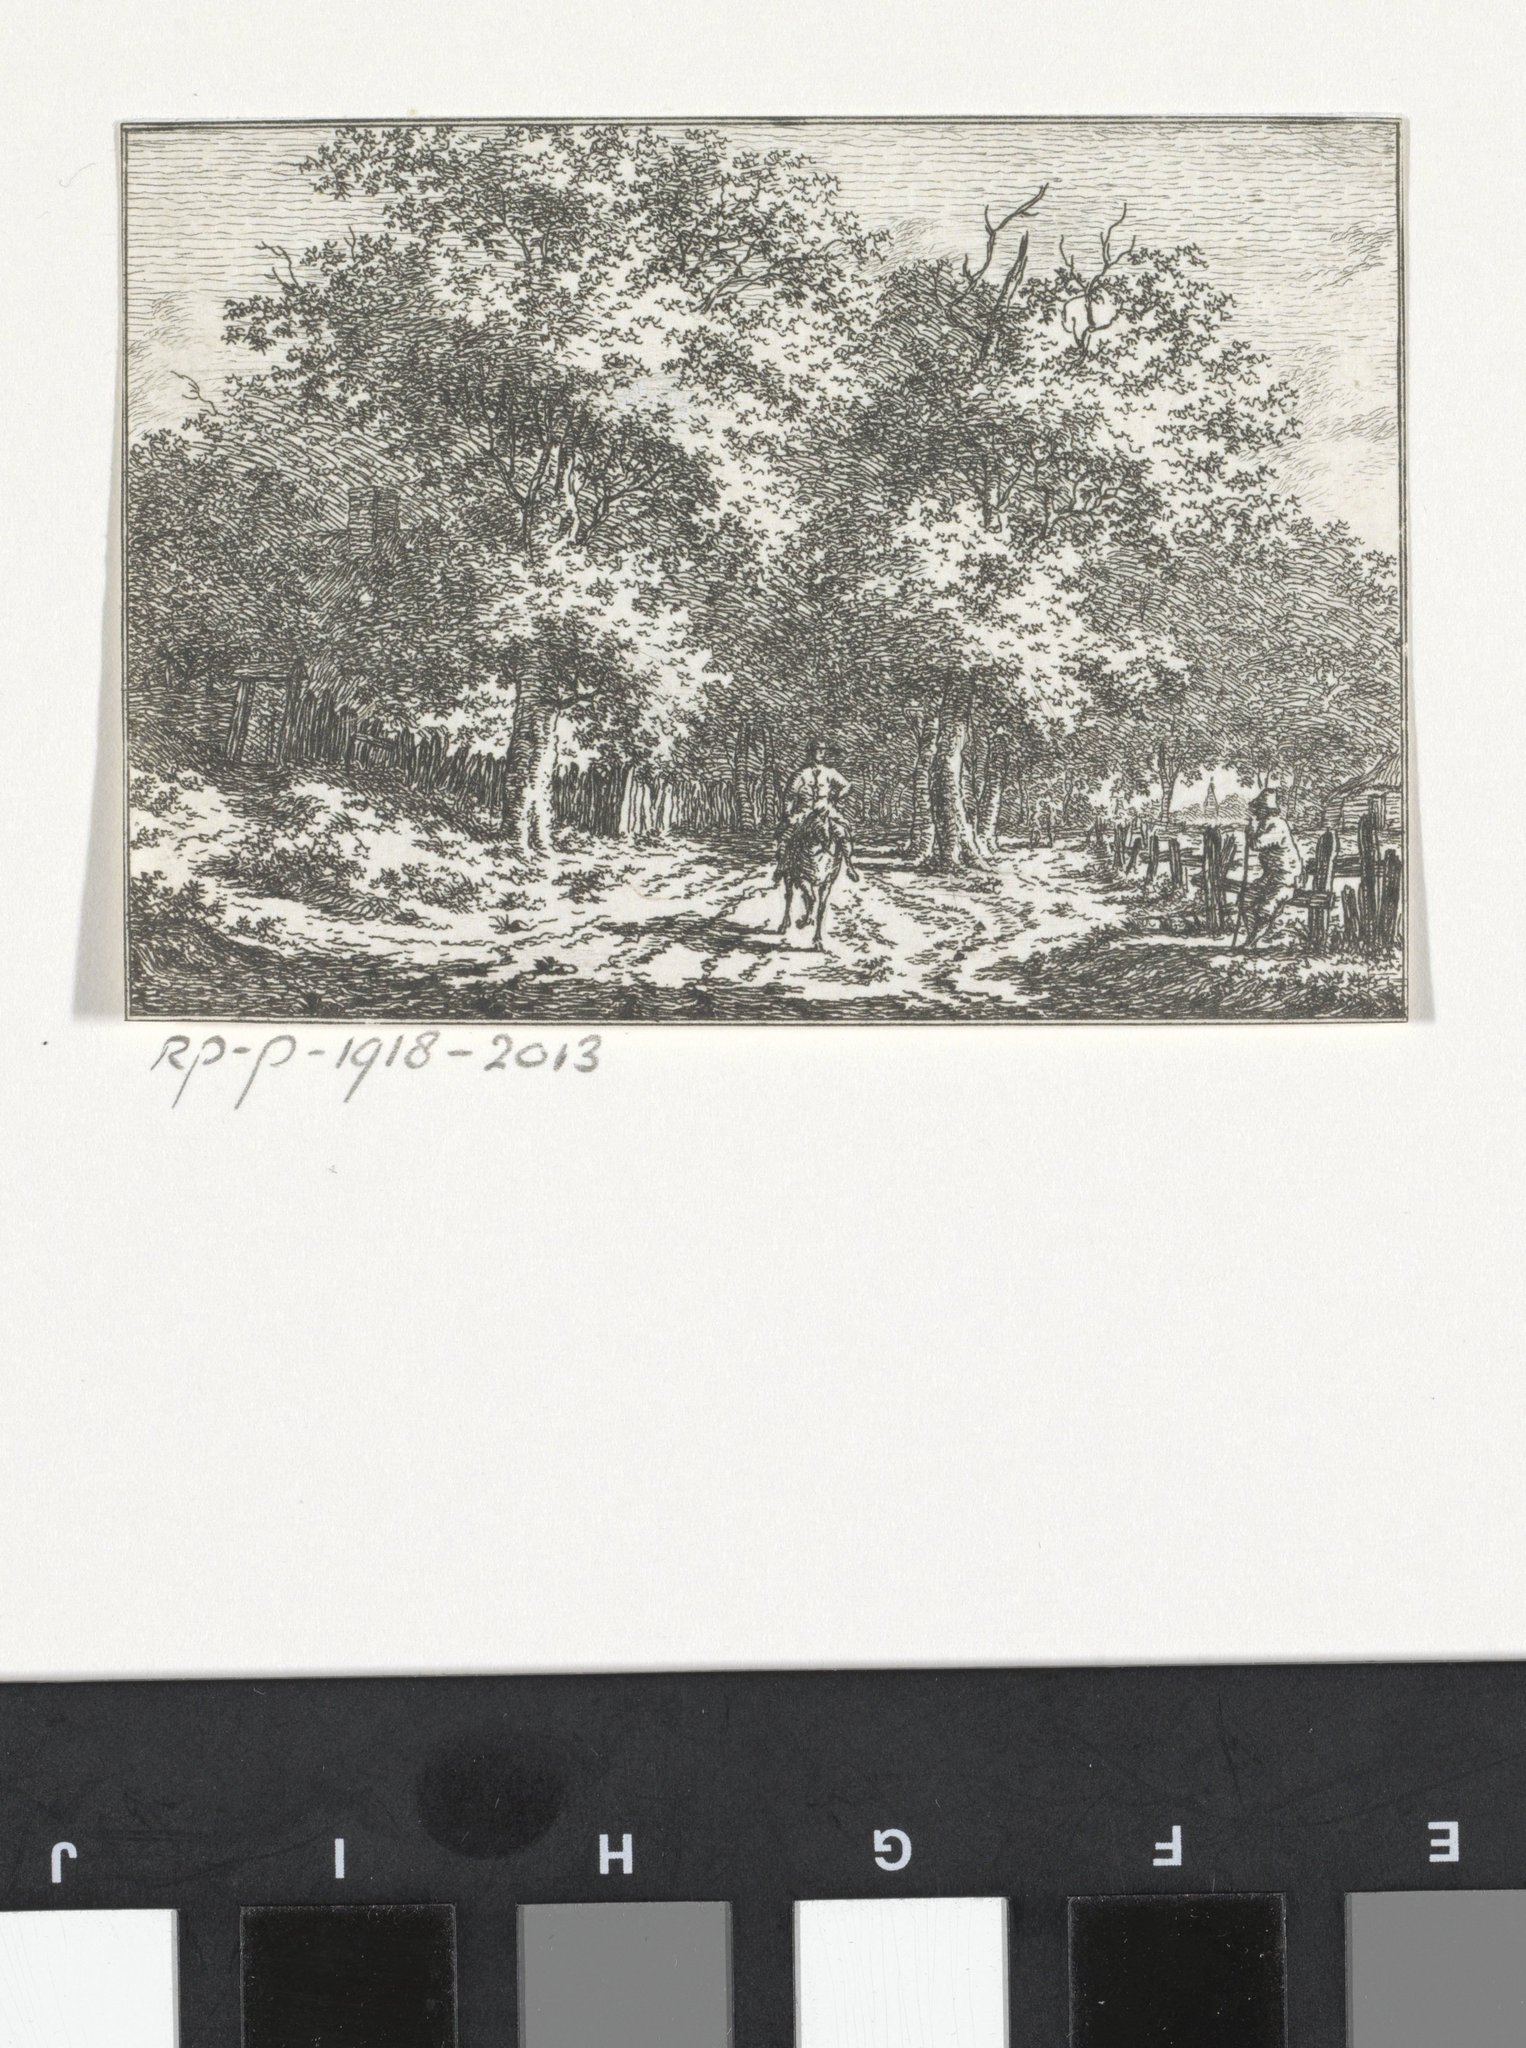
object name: print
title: Landschap met ruiter op een weg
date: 1774-1808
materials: paper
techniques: etching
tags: road, path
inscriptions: collector's mark: Lugt 2233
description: Een ruiter op een weg. De ruiter kijkt naar de man die rechts op een hek zit. Op de achtergrond bomen langs de weg.